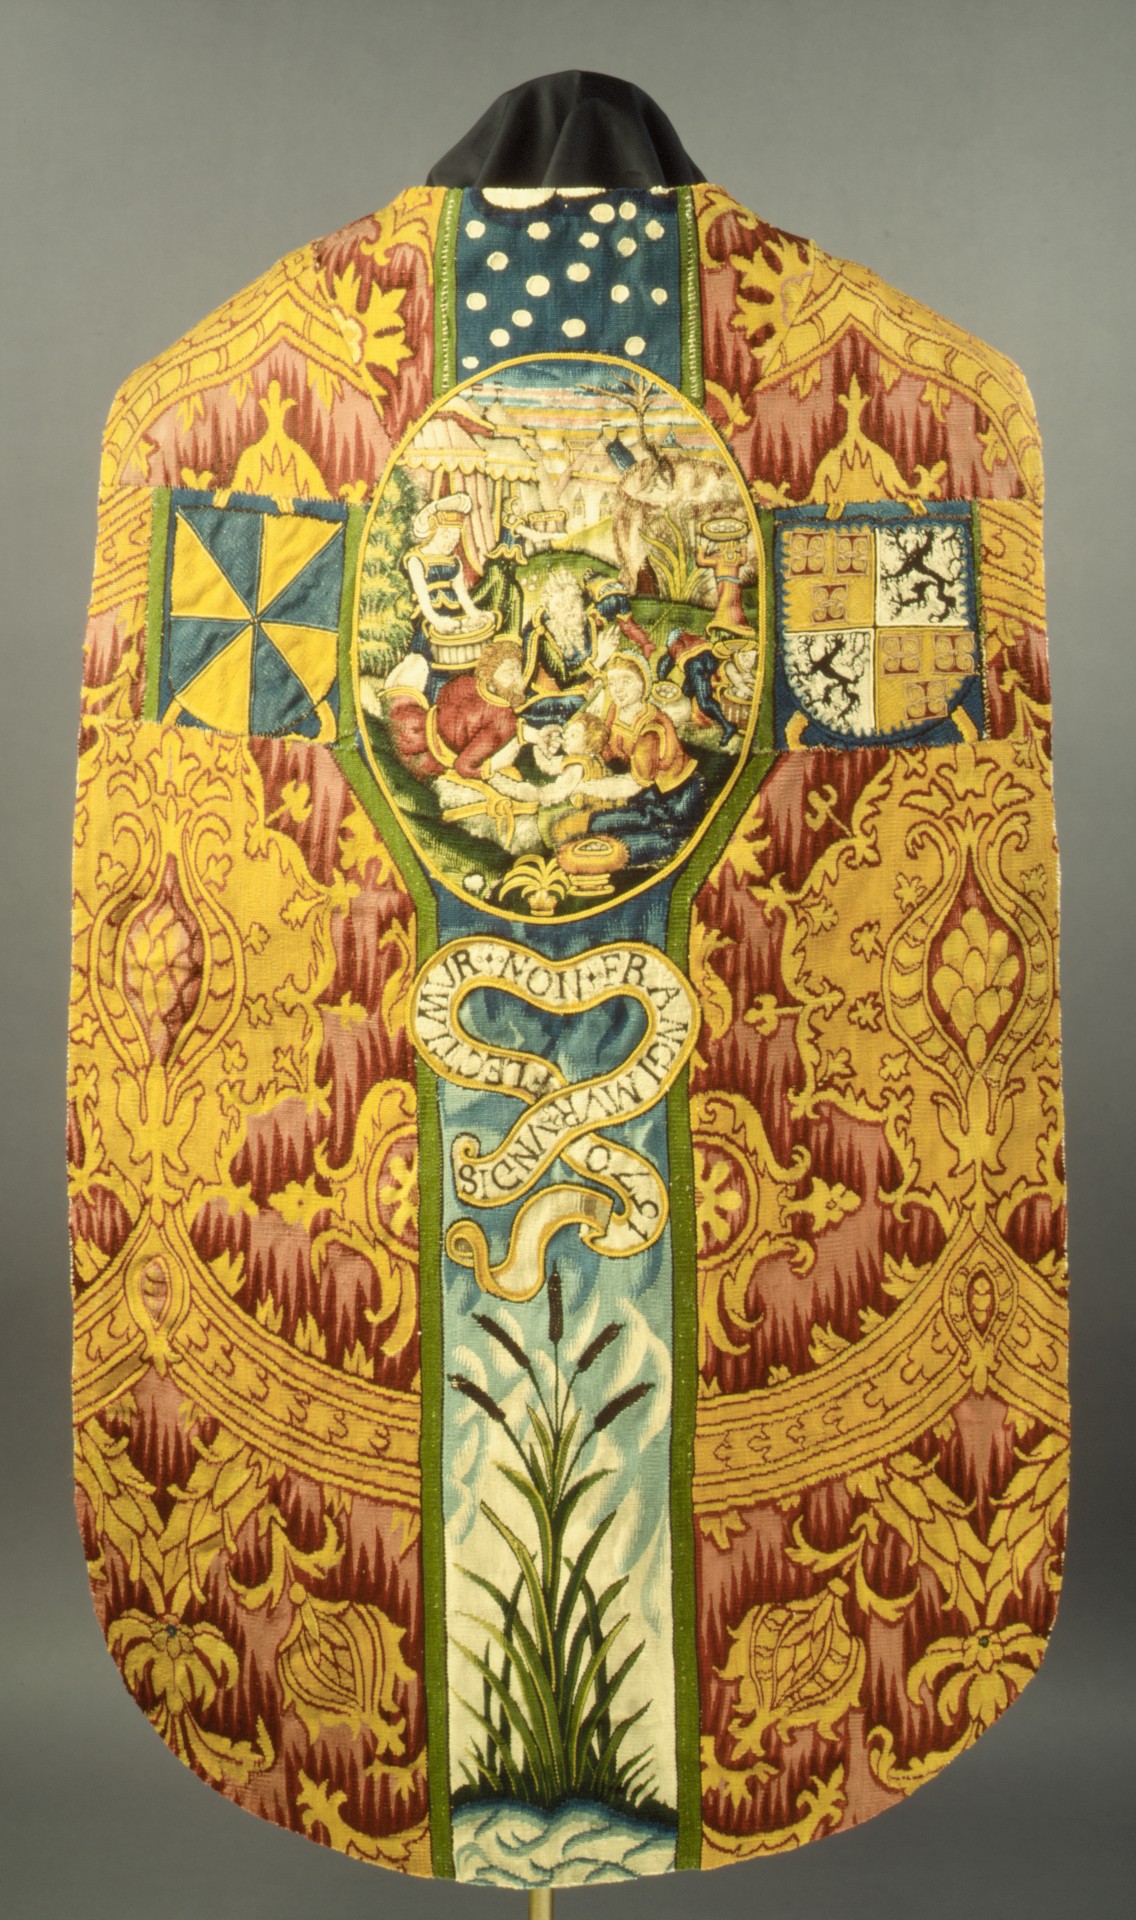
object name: vestment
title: Chasuble with the Gathering of the Manna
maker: hieronymus wierix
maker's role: artist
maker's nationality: netherlandish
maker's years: 1553-1619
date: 1570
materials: linen, silk, wool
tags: men,women,coat of arms,manna